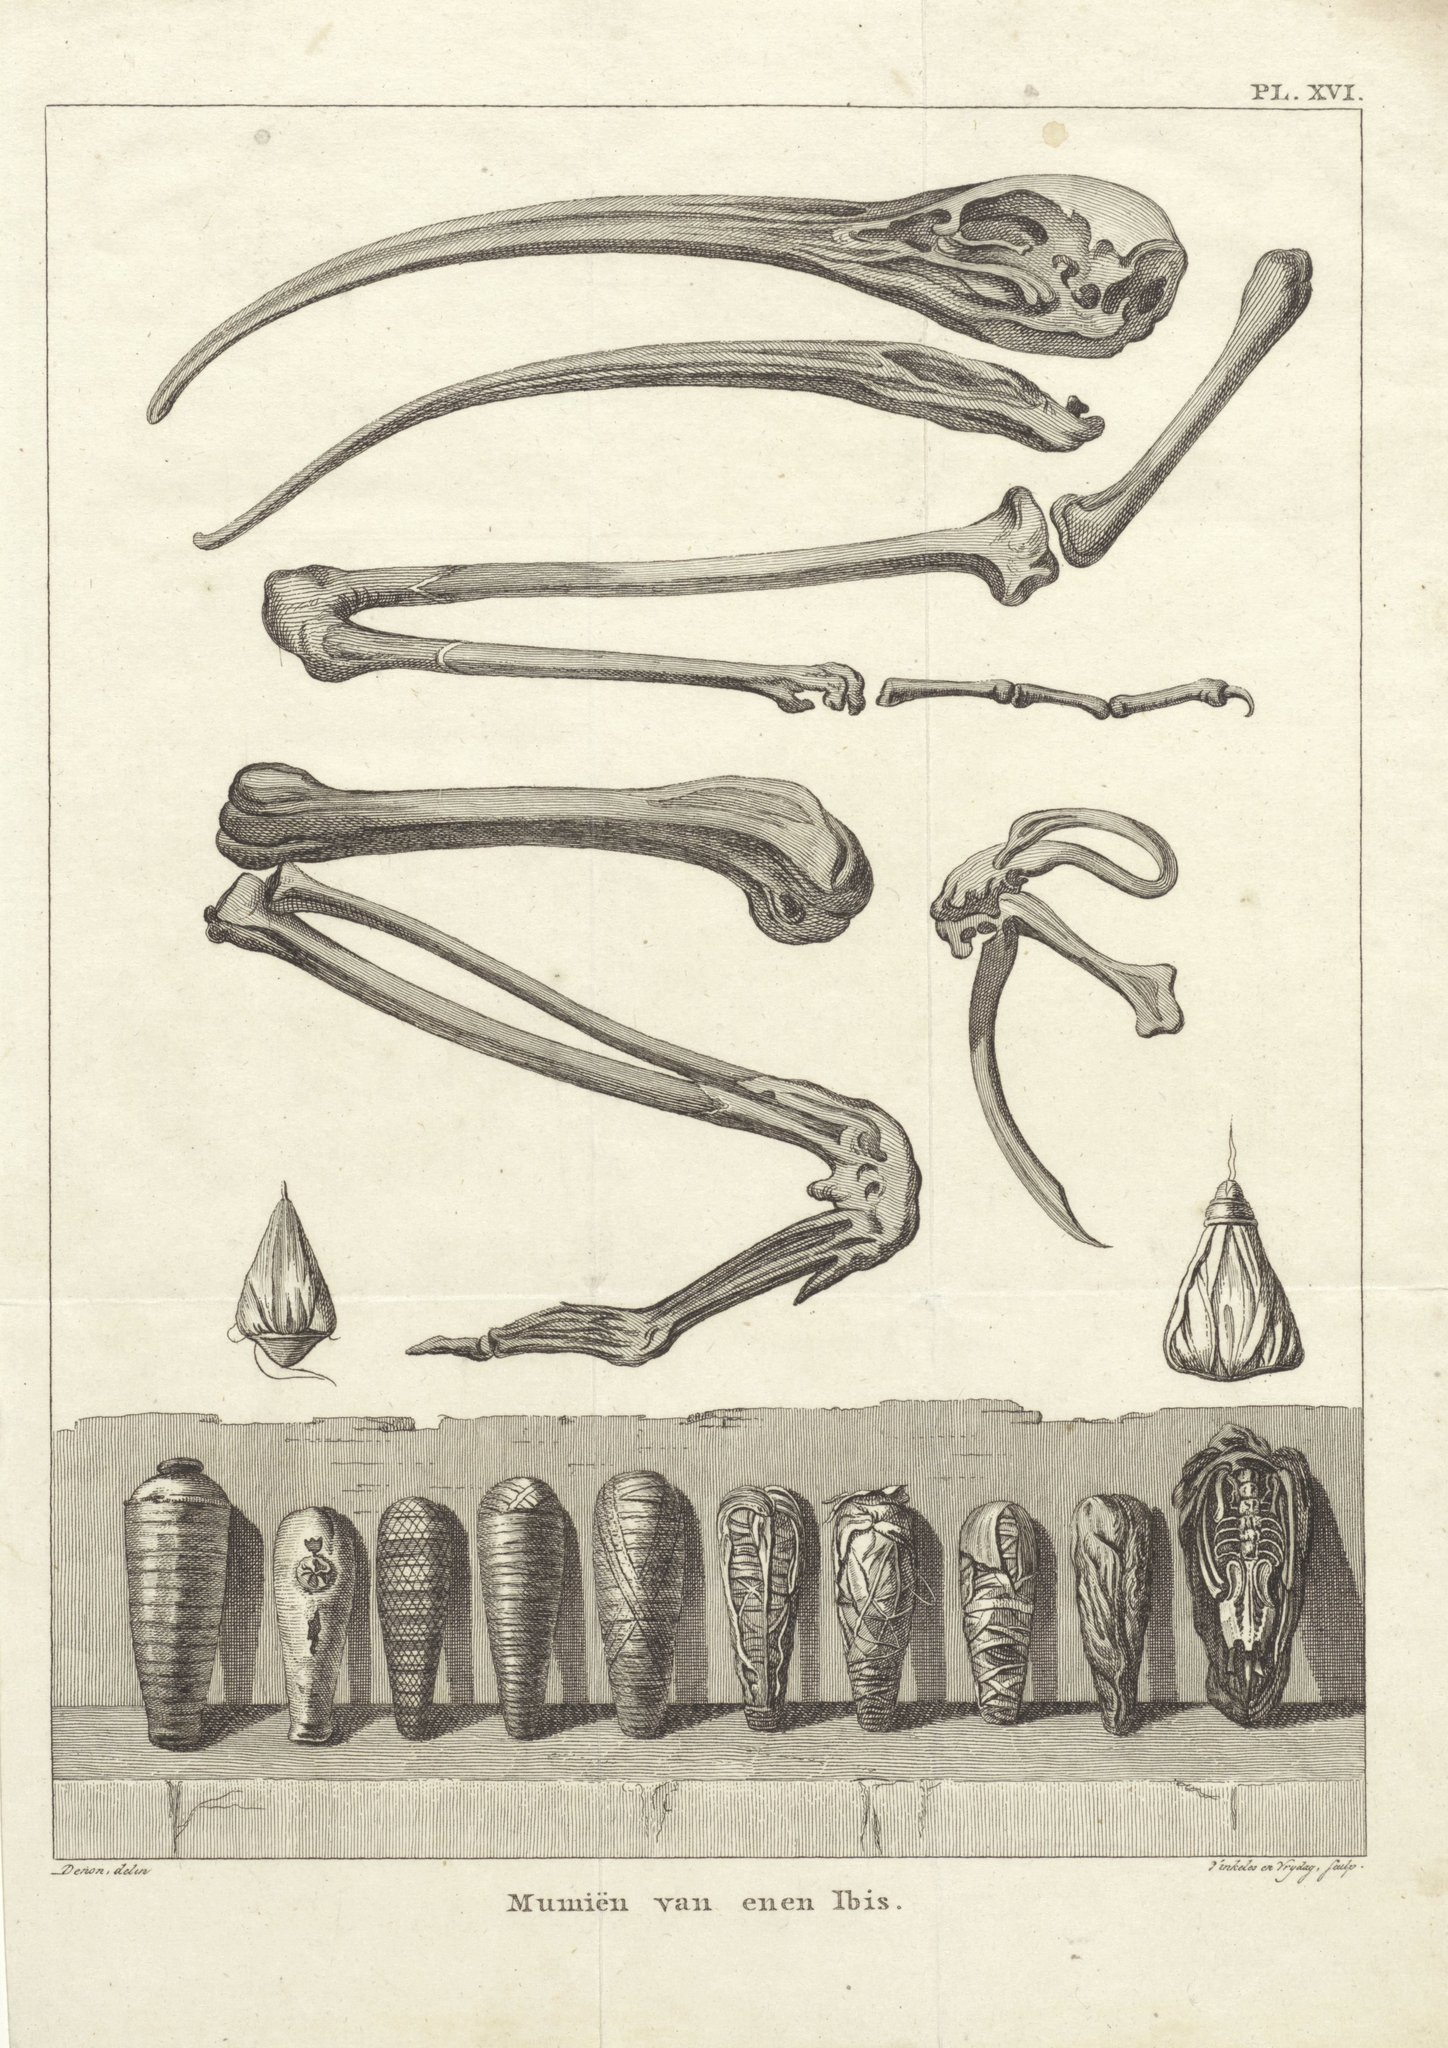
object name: book illustration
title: Beenderen en gemummificeerde Ibissen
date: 1803-1805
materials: paper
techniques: etching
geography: amsterdam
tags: shore-birds and wading-birds: ibis (+ dying animal; death of animal; dead animal), mummy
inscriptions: collector's mark: Lugt 2228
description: Prent vermoedelijk gebruikt in: Denon, Dominique Vivant [vertaald door Herman Bosscha]. Reize in Opper- en Neder-Egipte, gedurende den veldtocht van Bonaparte. 3 dln. Amsterdam: Johannes Allart, 1803-1805.